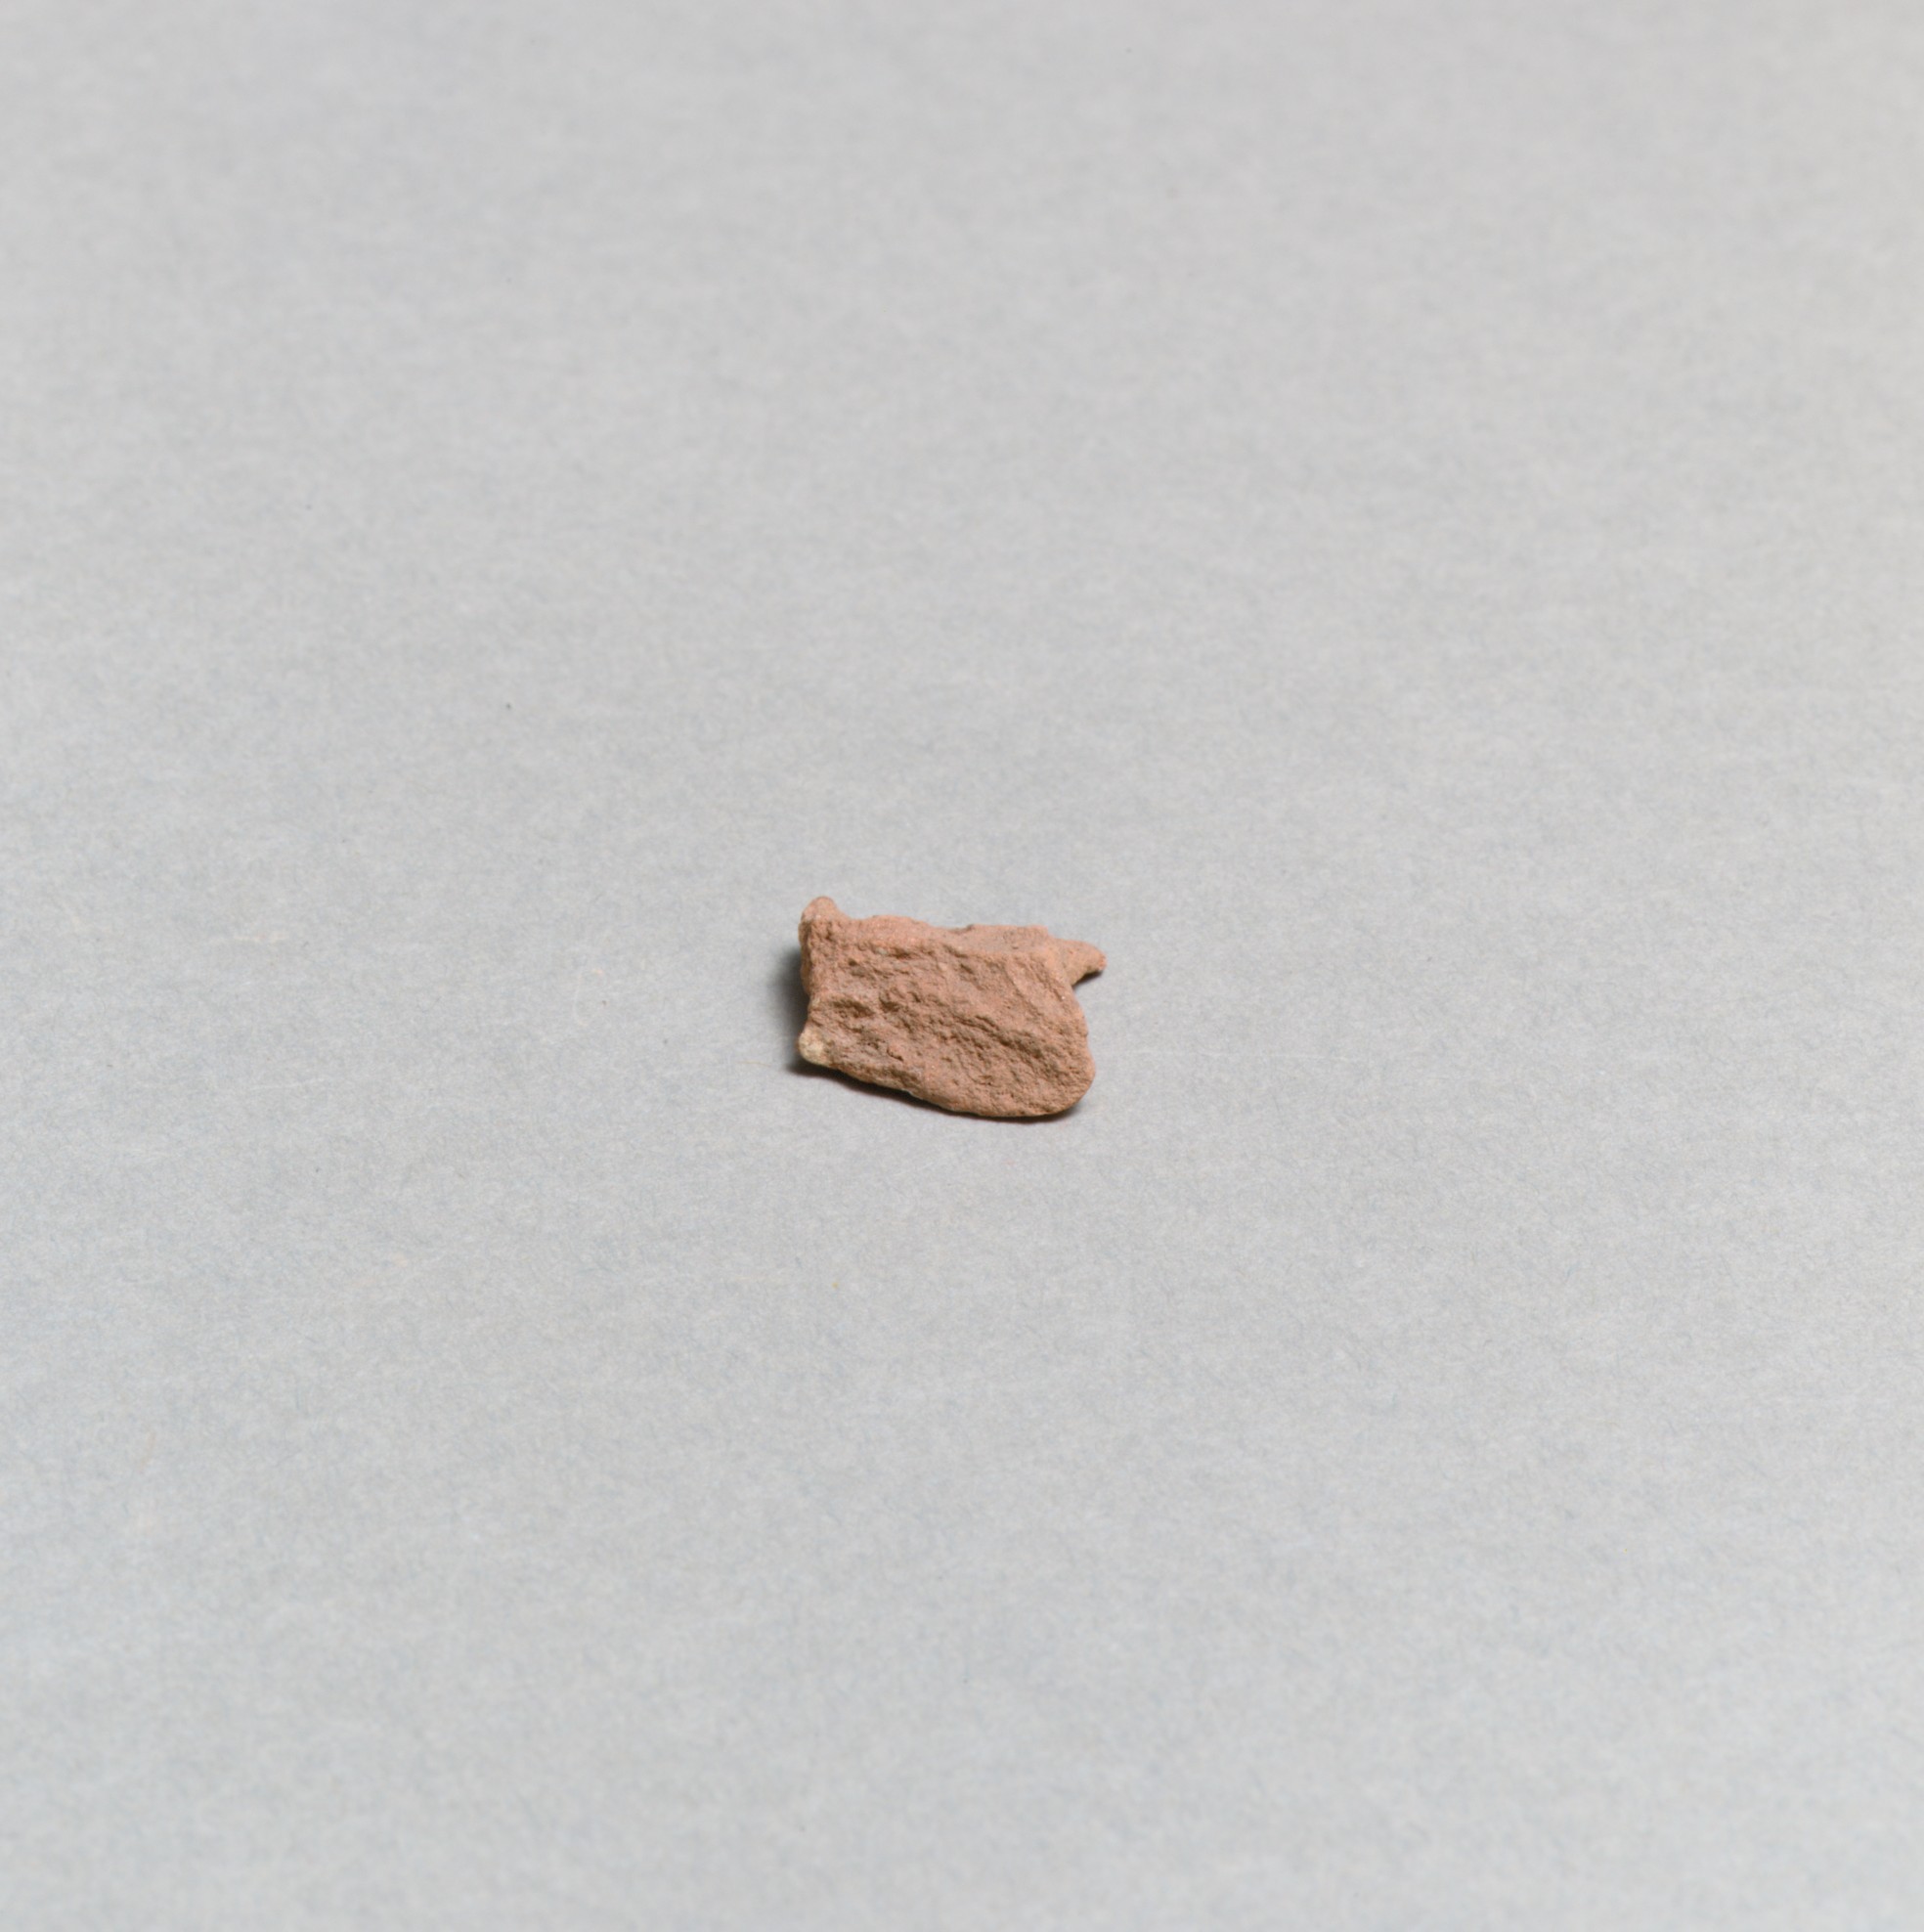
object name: vase fragment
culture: greek or lydian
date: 900-30 BCE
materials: terracotta